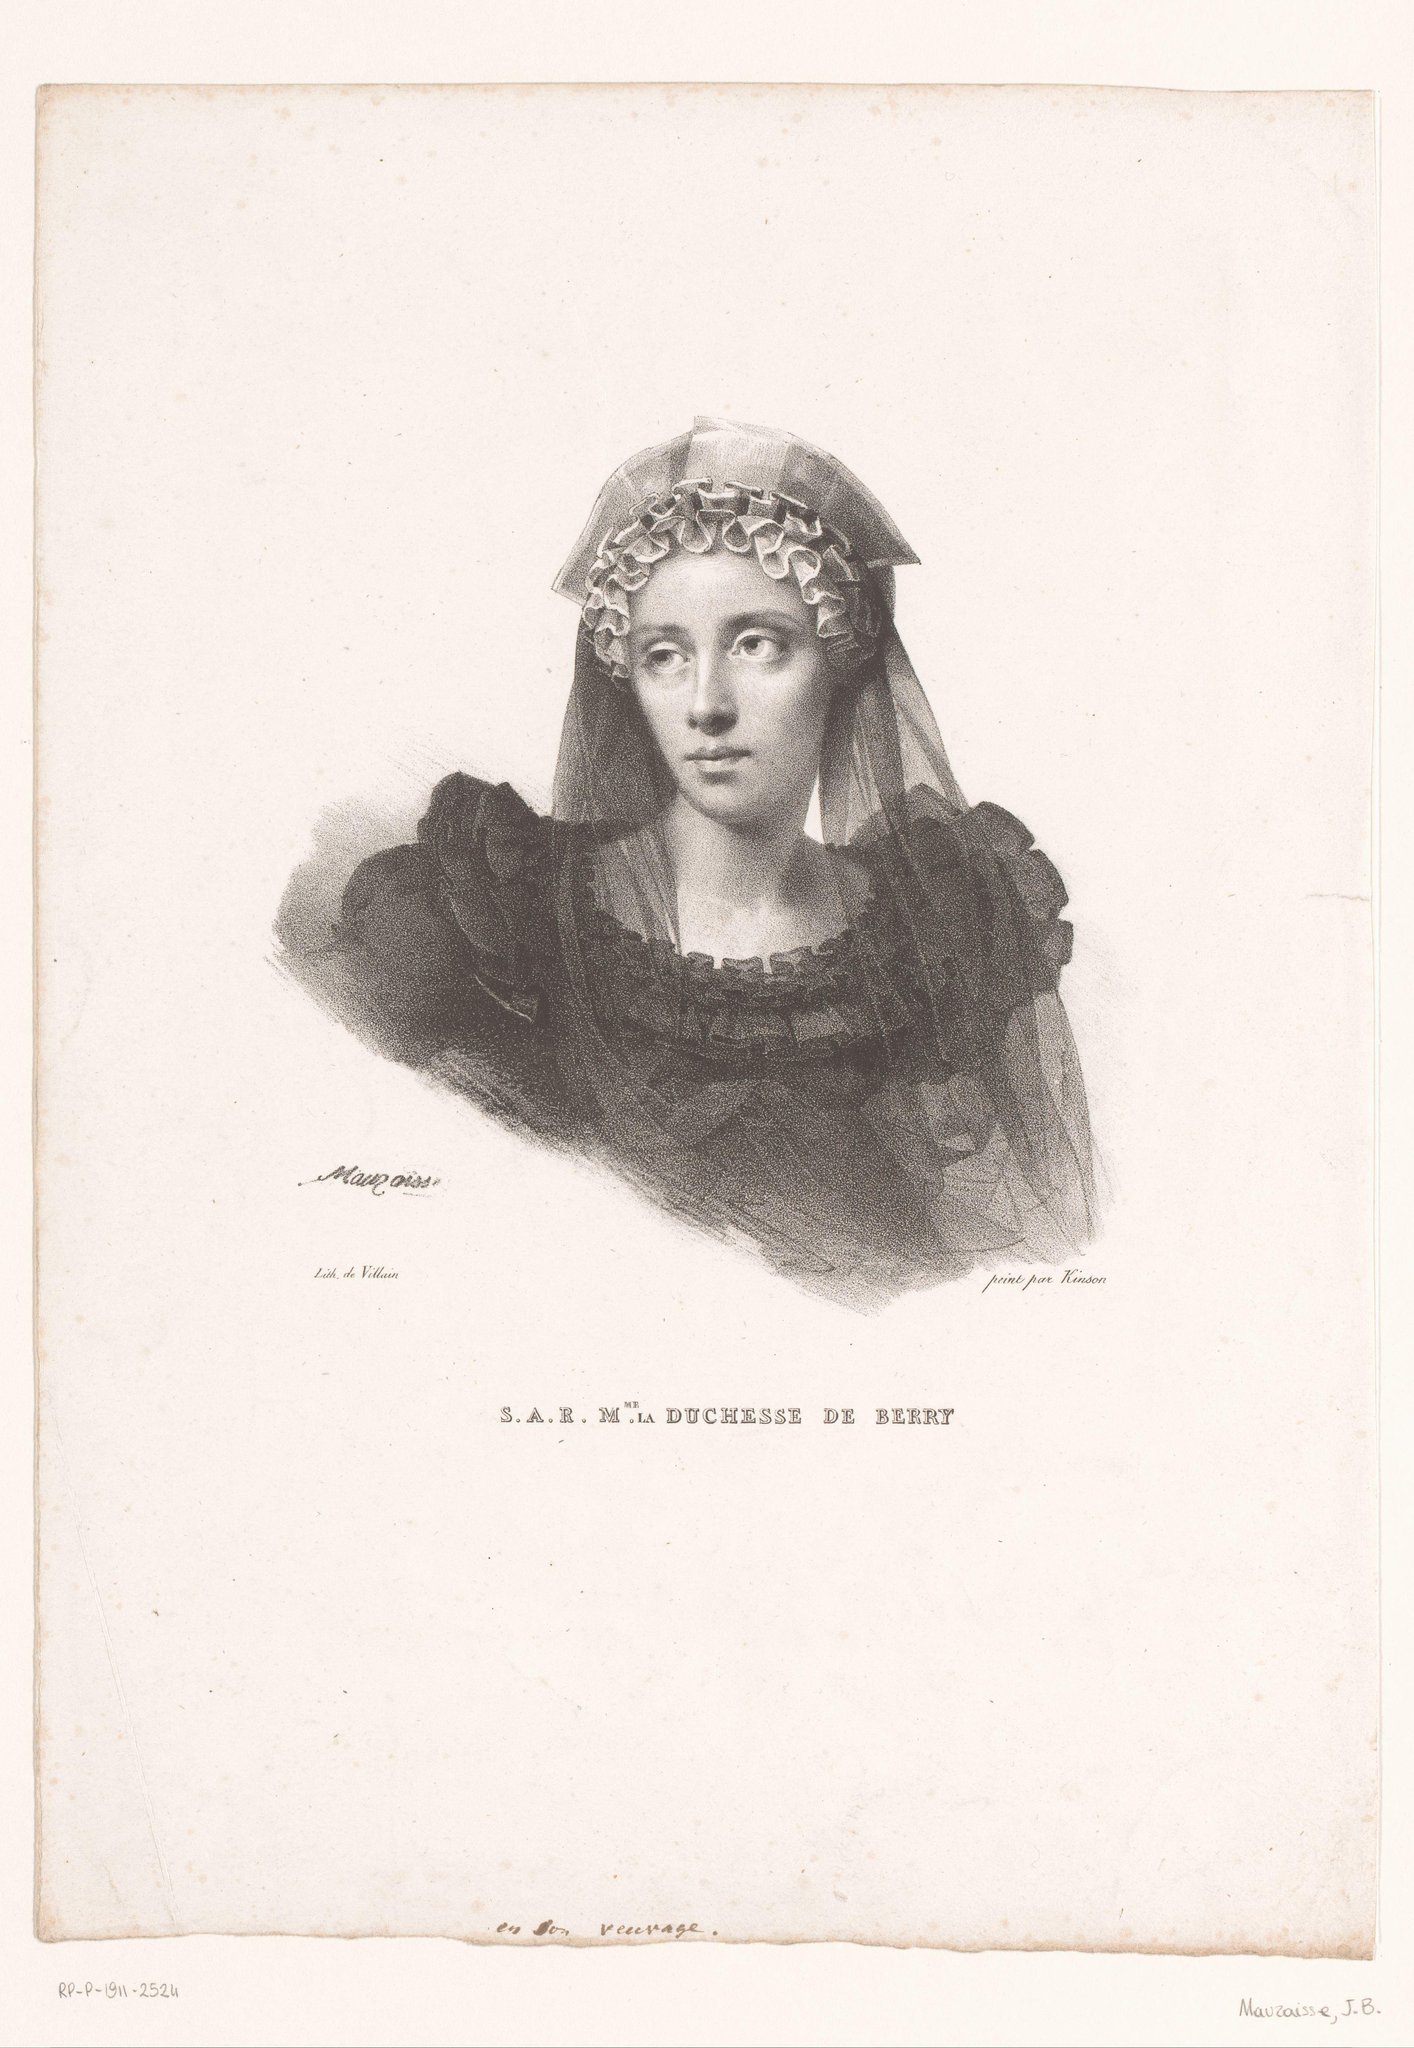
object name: print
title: Portret van Maria Carolina van Bourbon-Sicilië, hertogin van Berry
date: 1820-1852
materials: paper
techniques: lithograph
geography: paris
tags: maria carolina van bourbon-sicilië, historical persons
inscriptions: collector's mark: Lugt 2228